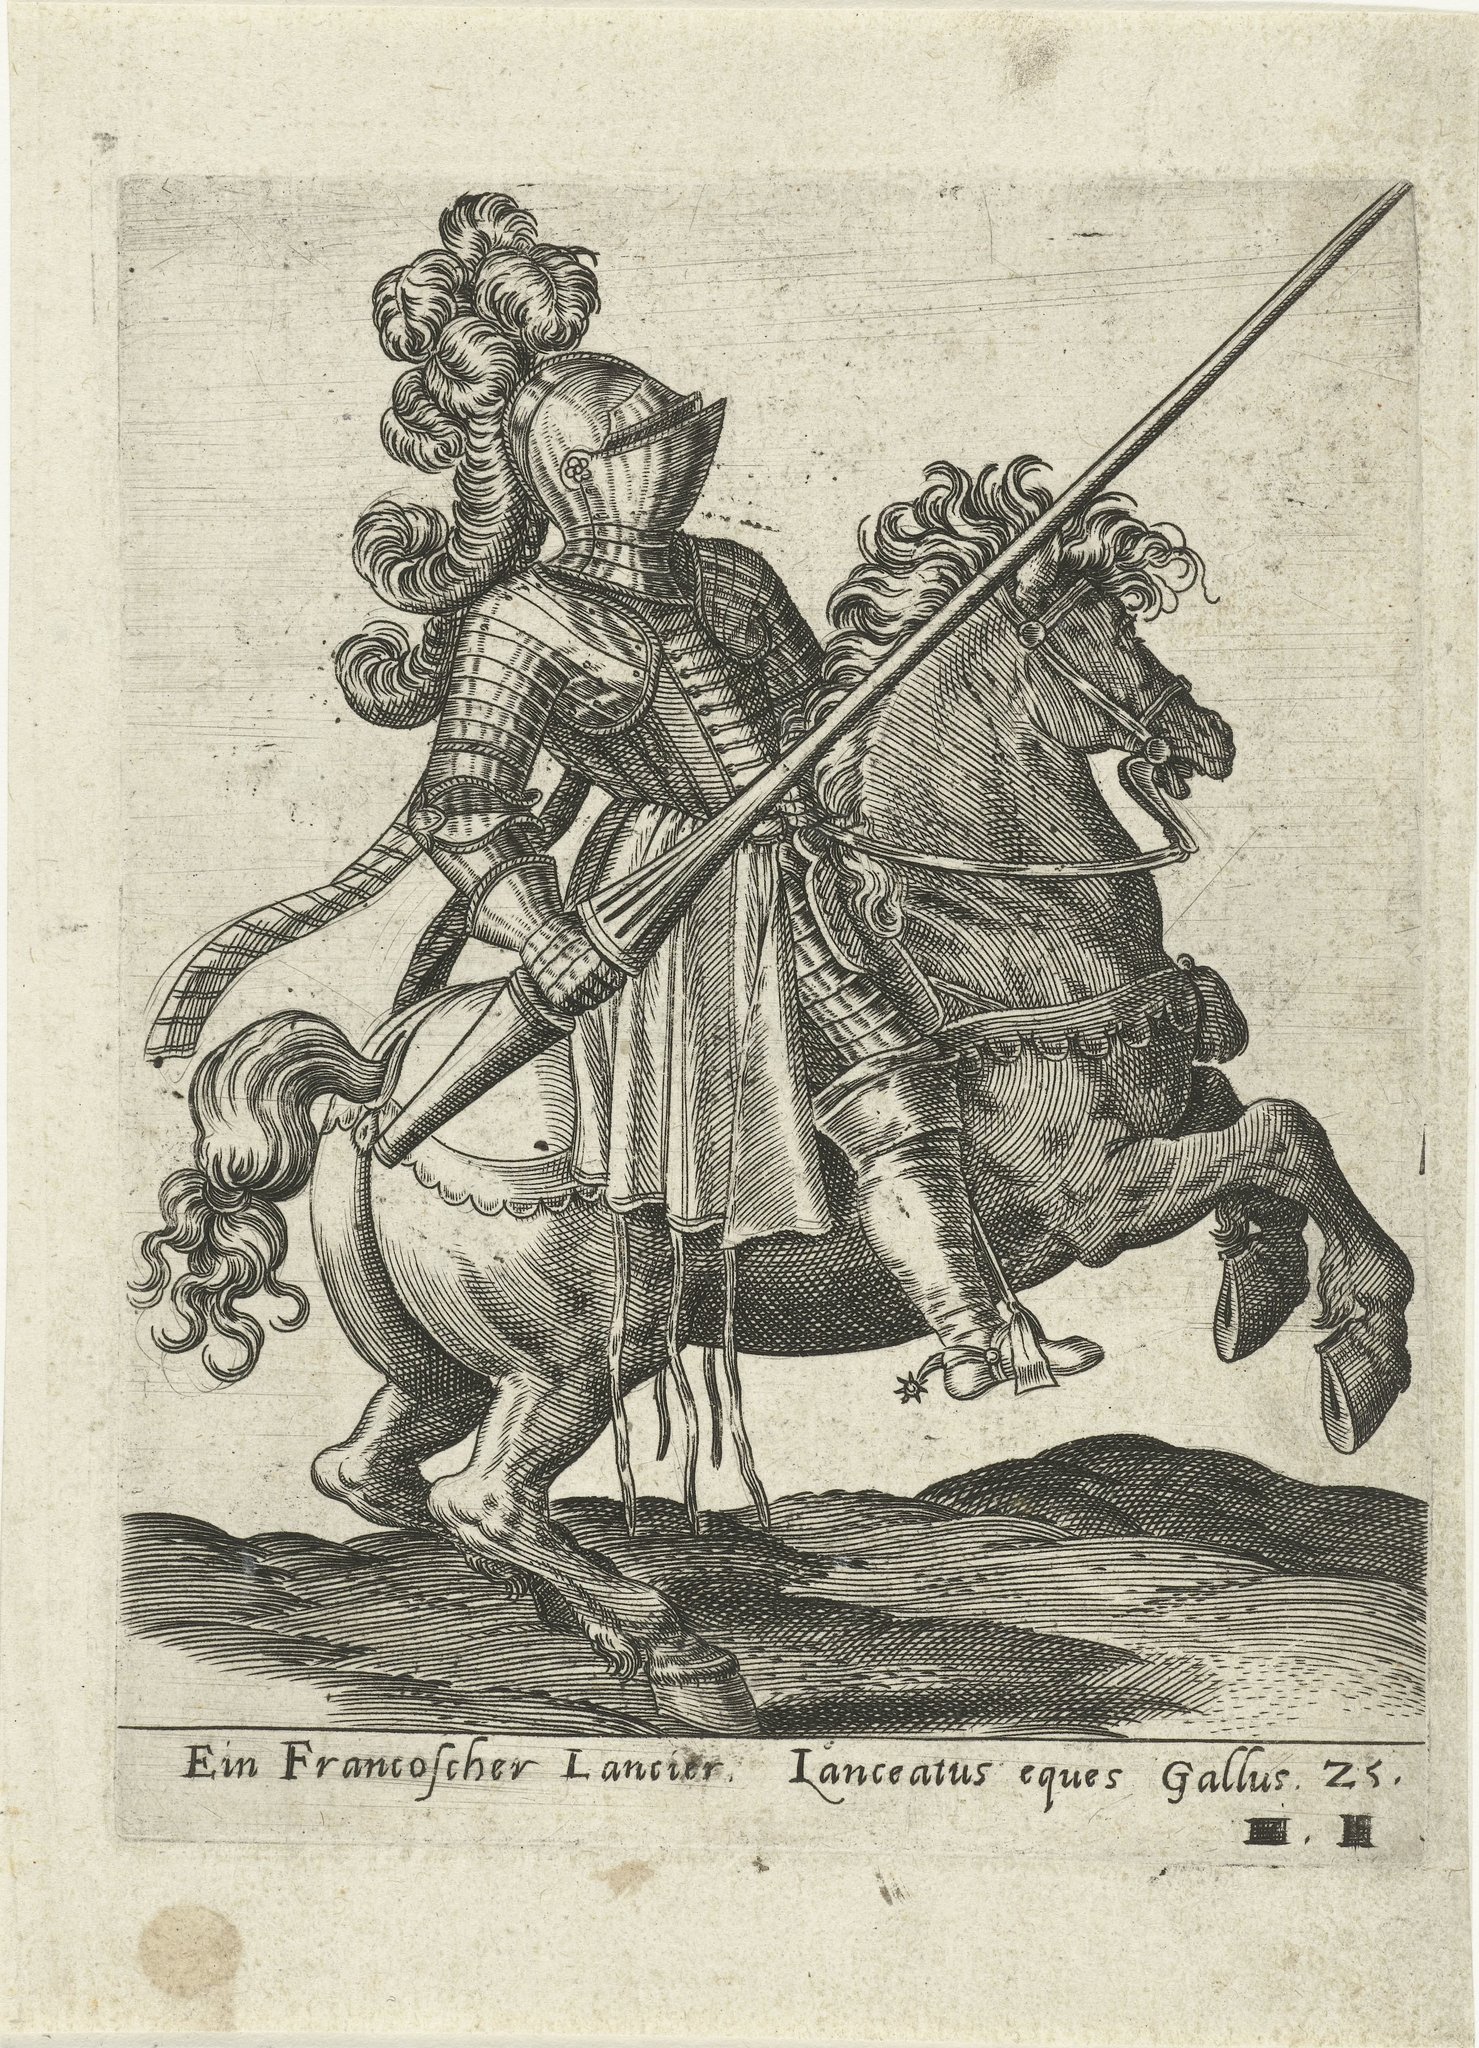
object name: costume print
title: Franse lansier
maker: abraham de bruyn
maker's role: print maker, publisher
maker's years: 1540-1587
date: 1577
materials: paper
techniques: engraving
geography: cologne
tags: europeans (with name), warfare; military affairs (+ cavalry, horsemen), folk costume, regional costume, military clothing and other equipment (uniforms, cap, armour, helmet, etc.)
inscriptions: collector's mark: Lugt 2228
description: Paard en ruiter naar rechts. Het paard steigert. De Franse ruiter heeft een lans in zijn handen en is volledig geharnast. De prent heeft een Duits en een Latijns onderschrift. Prent oorspronkelijk uit 'Equitum descripcio...', 1577.